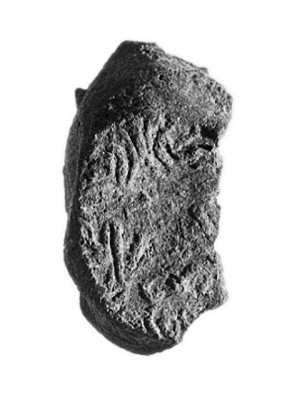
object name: sealing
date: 1981-1640 BCE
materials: mud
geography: egypt